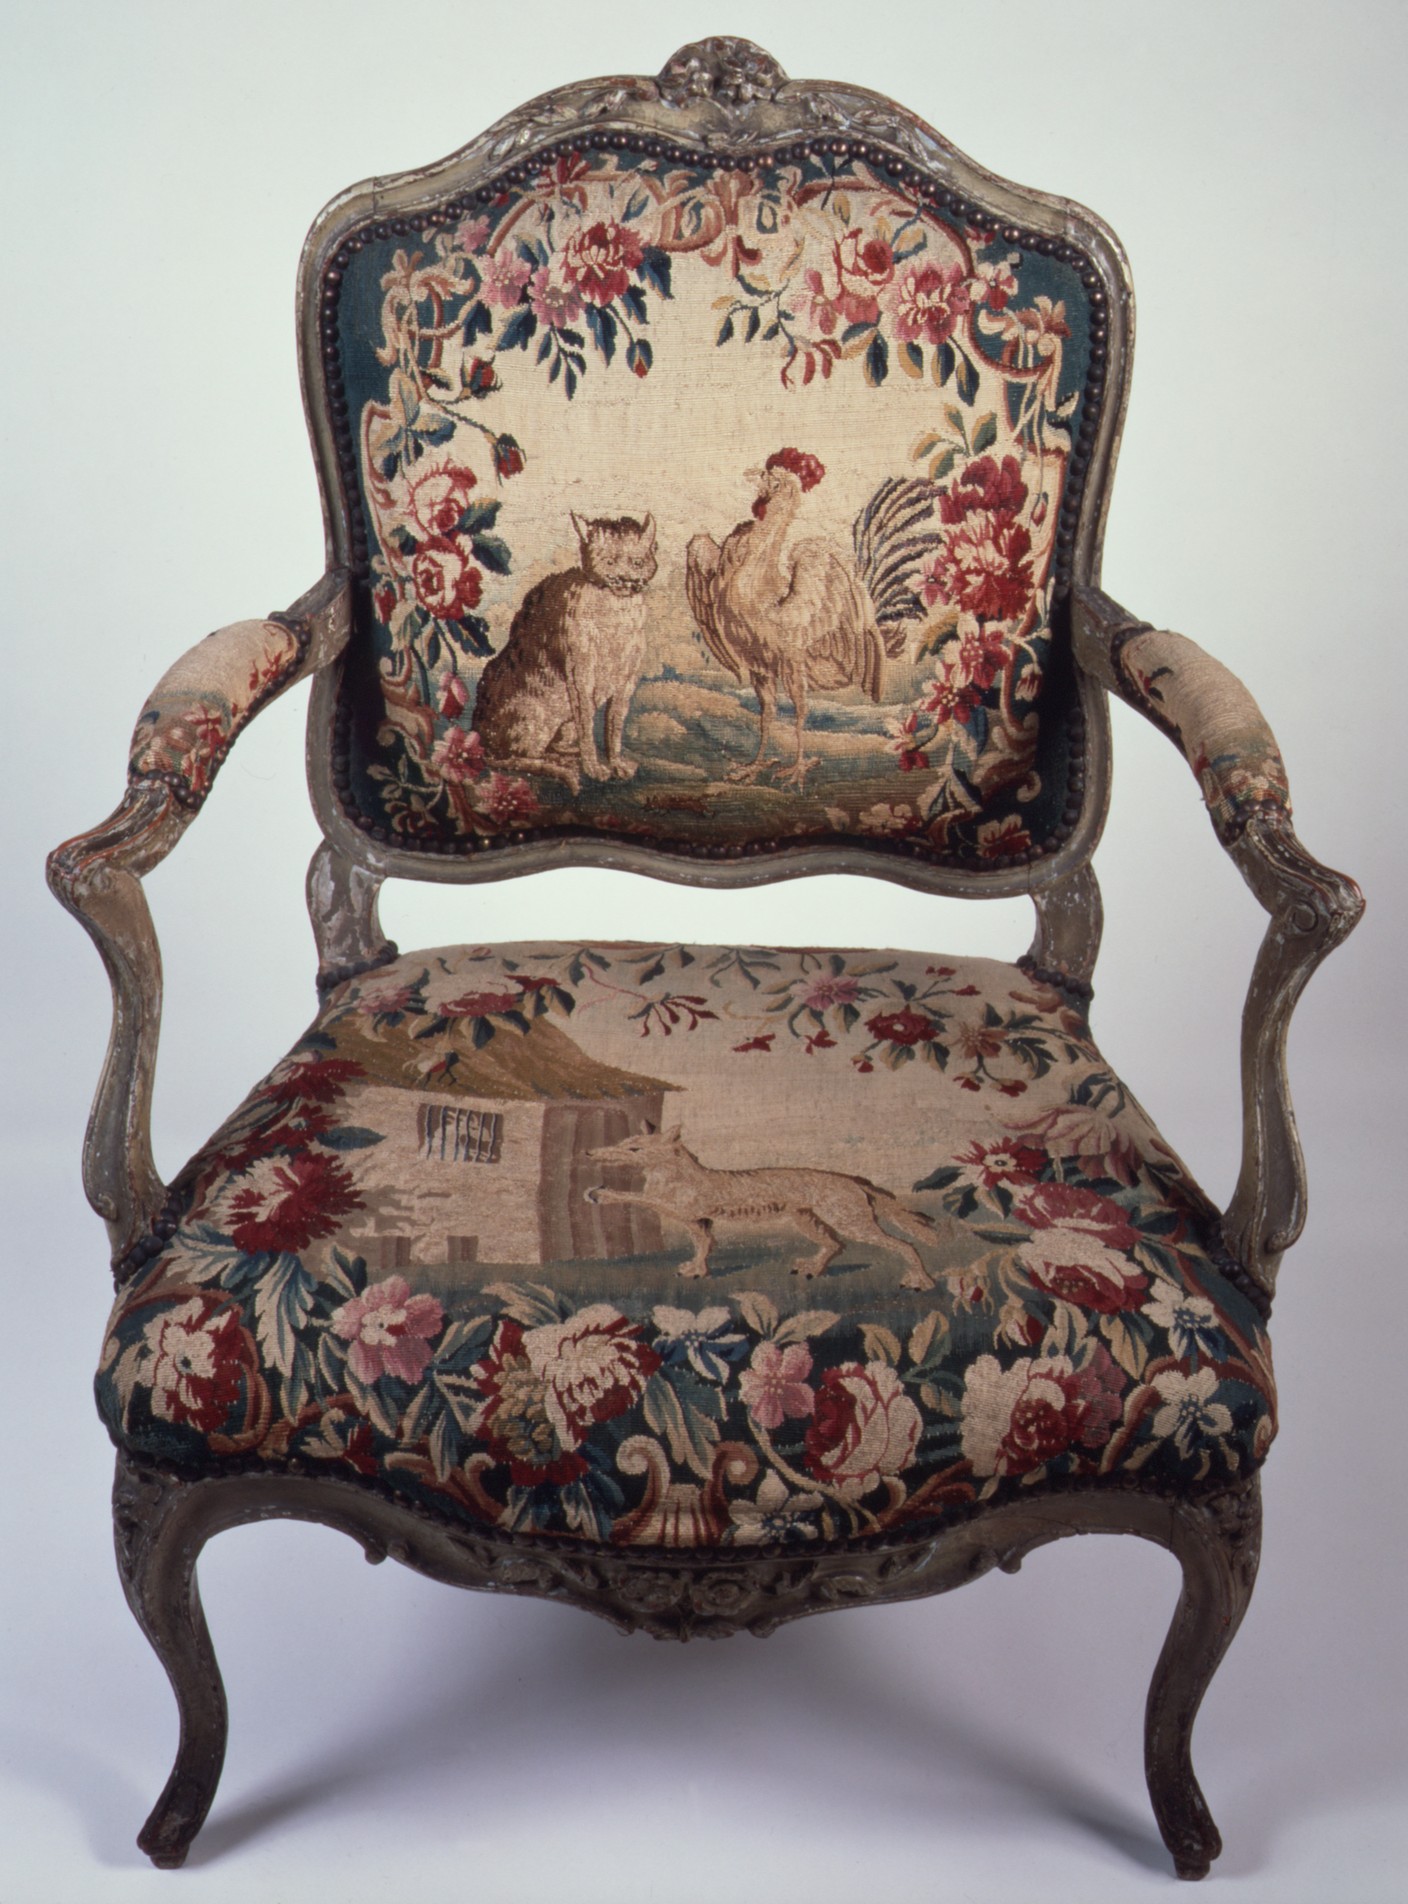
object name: armchair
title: Armchair (part of a set of nine)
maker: aubusson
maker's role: factory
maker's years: 1665-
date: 1734-1766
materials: wood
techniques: carving, painting, tapestry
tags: roosters,cats,flowers